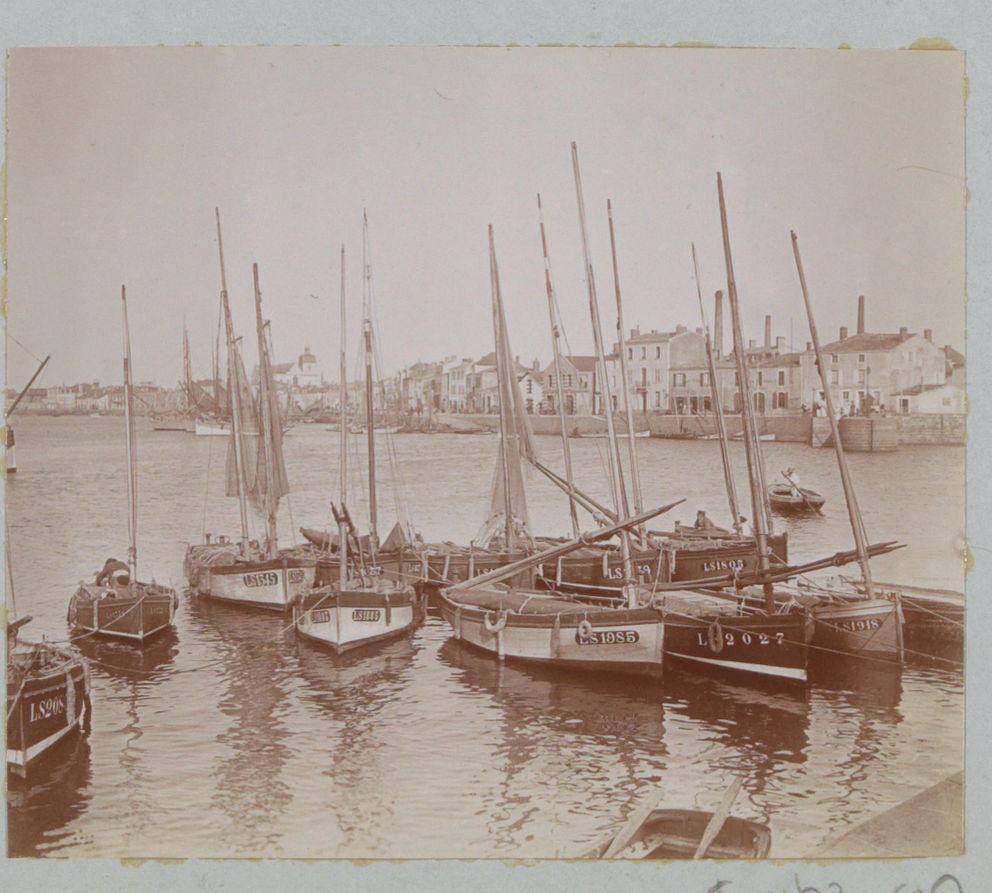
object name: photograph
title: Boten voor anker in een haven in Frankrijk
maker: Anonymous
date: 1905-1910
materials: paper, photographic support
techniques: gelatin silver print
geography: france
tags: sailing-ship, sailing-boat, harbour (+ view ~ vehicle, ship, etc.), france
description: Onderdeel van Fotoalbum van een Franse amateurfotograaf met bezienswaardigheden in Frankrijk, Zwitserland en Italië.